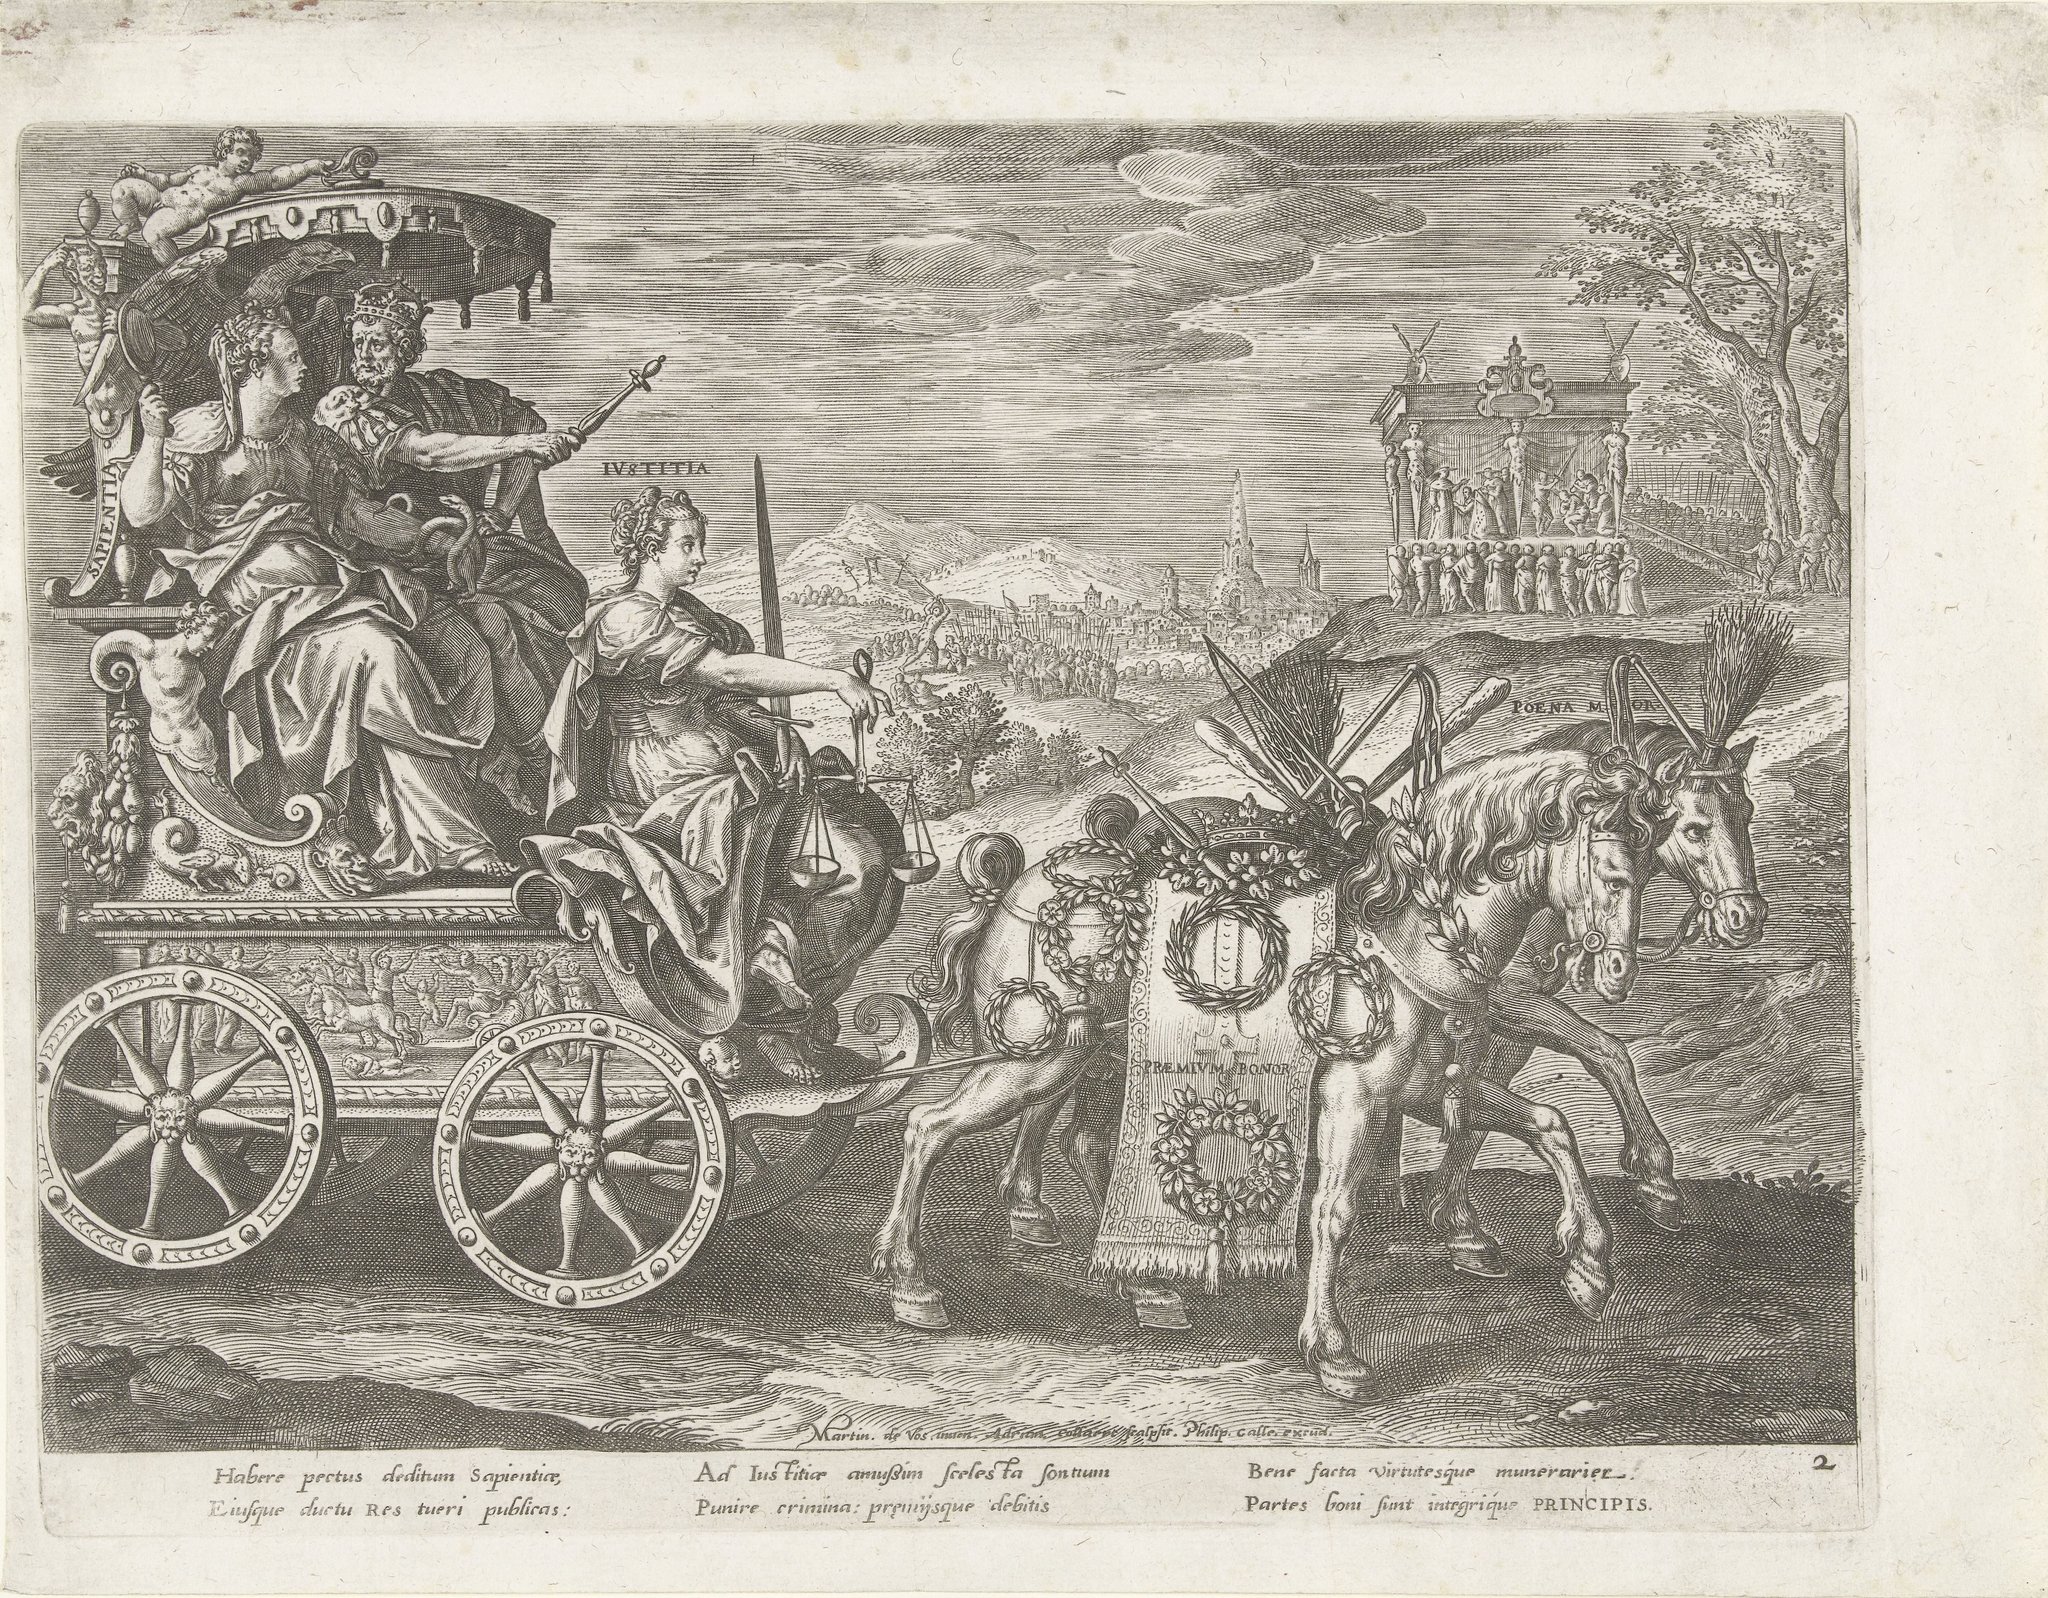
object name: print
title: Taak van de adel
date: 1583-1588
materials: paper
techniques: engraving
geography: antwerp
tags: wisdom; 'sapienza', 'sapienza humana', 'sapienza vera' (ripa), justice; 'forza alla giustitia sottoposta', 'giustitia', 'giustitia retta', 'giustitia rigorosa', 'impietà e violenza soggetta alla giustitia' (ripa), chamber of rhetoric (dutch: 'rederijkerskamer'), criminal law; punishment, instruments of torture, execution or punishment, the stage and its equipment, the three estates: nobility, clergy, commoners, reward, 'praemium'; 'premio', 'remuneratione' (ripa), punishment; 'castigo', 'pena', 'punitione' (ripa), nobility and patriciate; chivalry, knighthood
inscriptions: collector's mark: Lugt 2760, collector's mark: Lugt 2228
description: Een triomfwagen met de vertegenwoordiger van de wereldlijke macht, de koning. Naast hem zit de allegorische figuur van Wijsheid. De triomfwagen wordt getrokken door twee paarden, Beloning (versierd met lauwerkransen) en Bestraffing (versierd met tuchtigingsmiddelen zoals roede en zweep) en bestuurd door de allegorische figuur van Gerechtigheid. Op de achtergrond enkele taken van de wereldlijkheid: het straffen van misdadigers en ordehandhaving. Op een rederijkerspodium twee tableaus vivants: een van beloning en een van bestraffing . De prent heeft een Latijnse opschrift en een Latijns onderschrift en is deel van een vierdelige serie over de goddelijke taken van de drie standen.